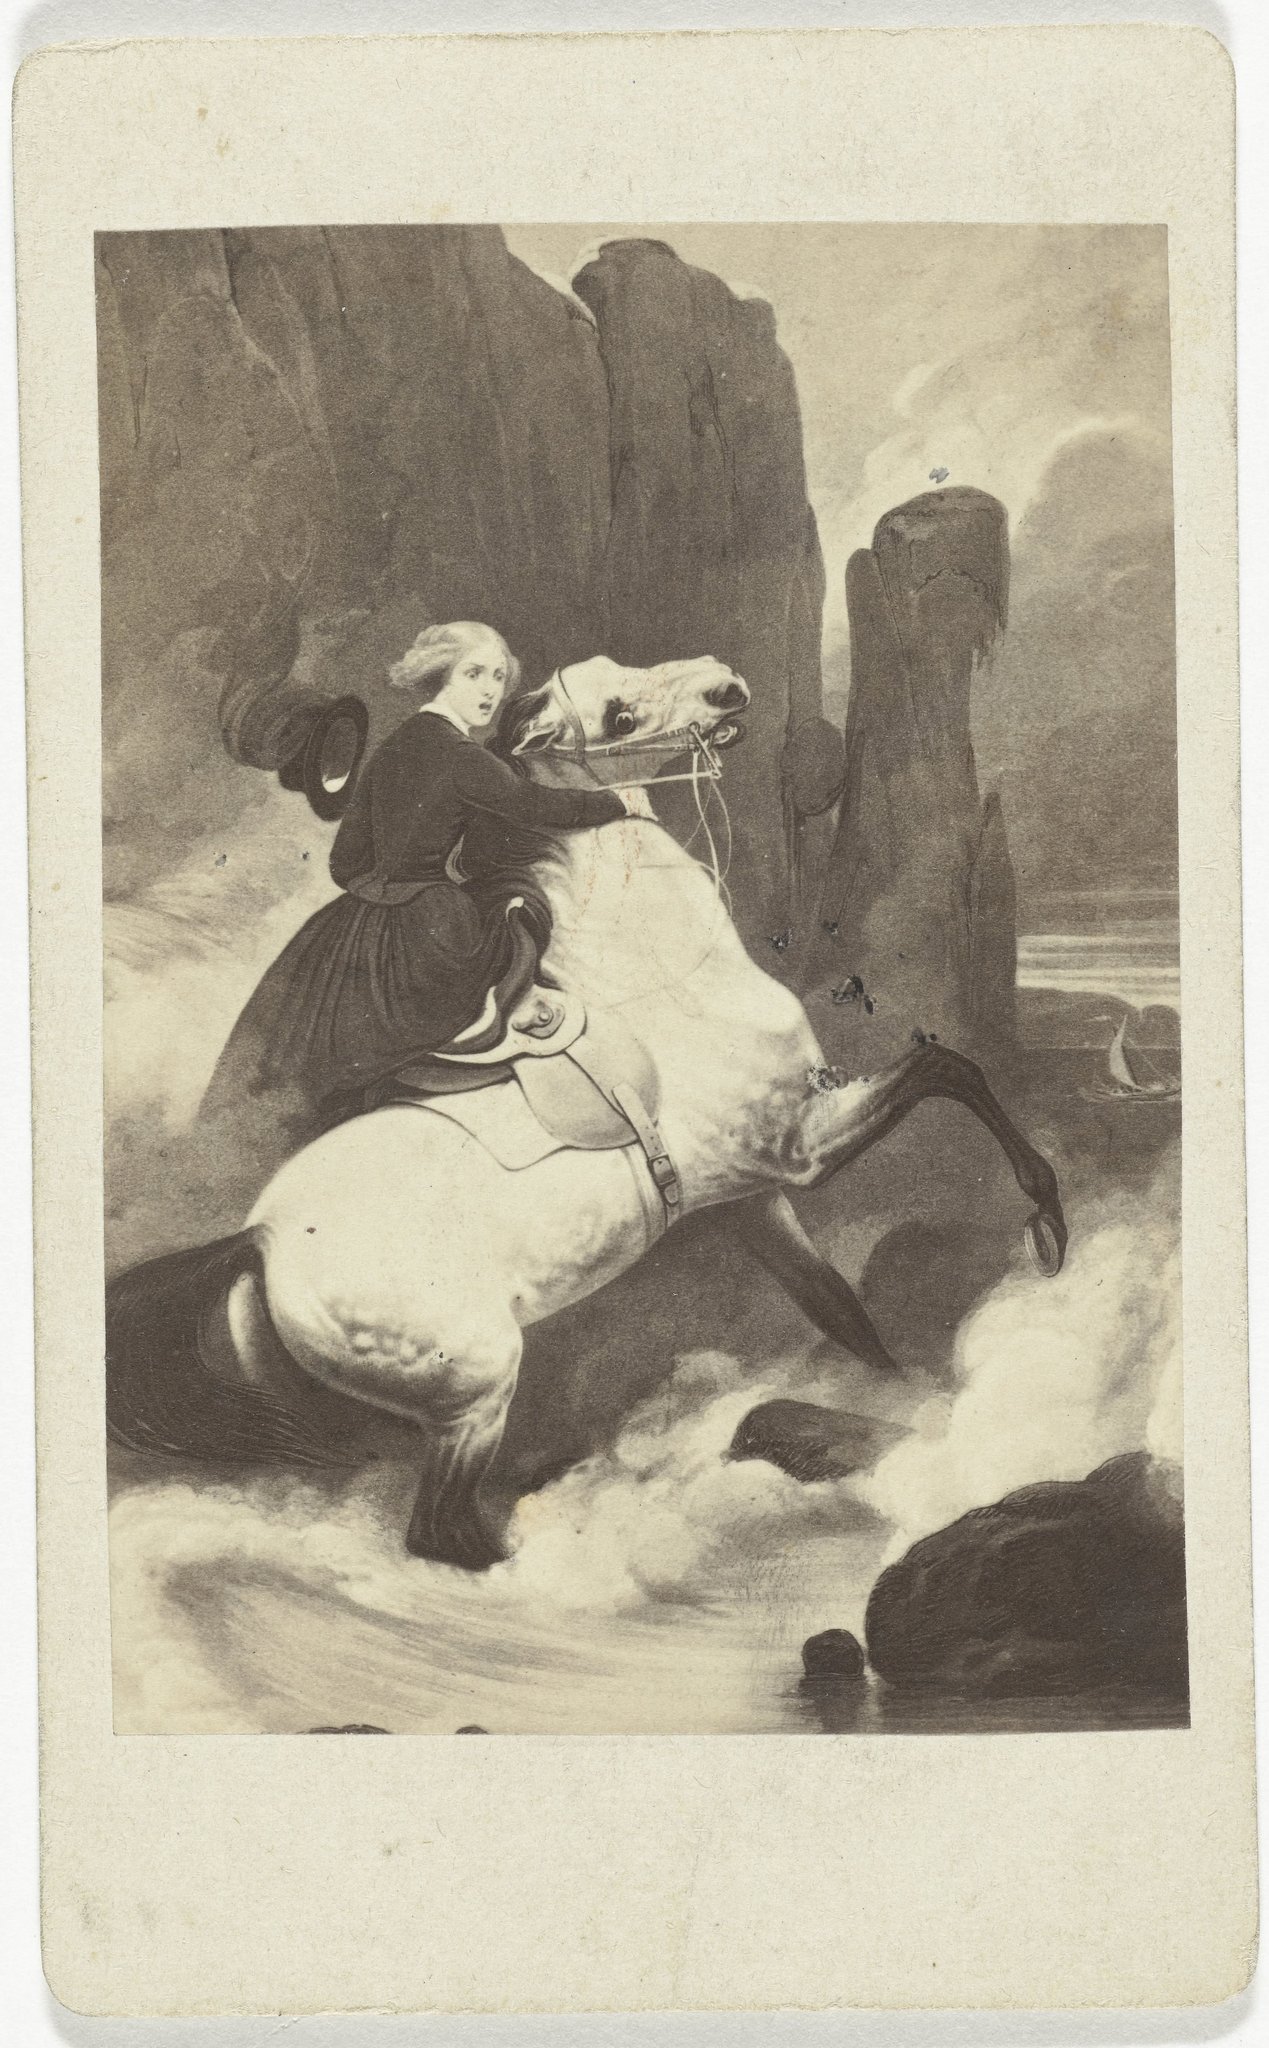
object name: carte de visite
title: Fotoreproductie van een ontwerp van een man te paard in het water door Henri Frédéric Schopin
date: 1850-1900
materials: cardboard, photographic support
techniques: albumen print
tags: riding a horse, ass, or mule; rider, horseman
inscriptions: number: ‘50-’, inscription: ‘1821. / Chopin. / Amerika. / L'Amerique / America.’